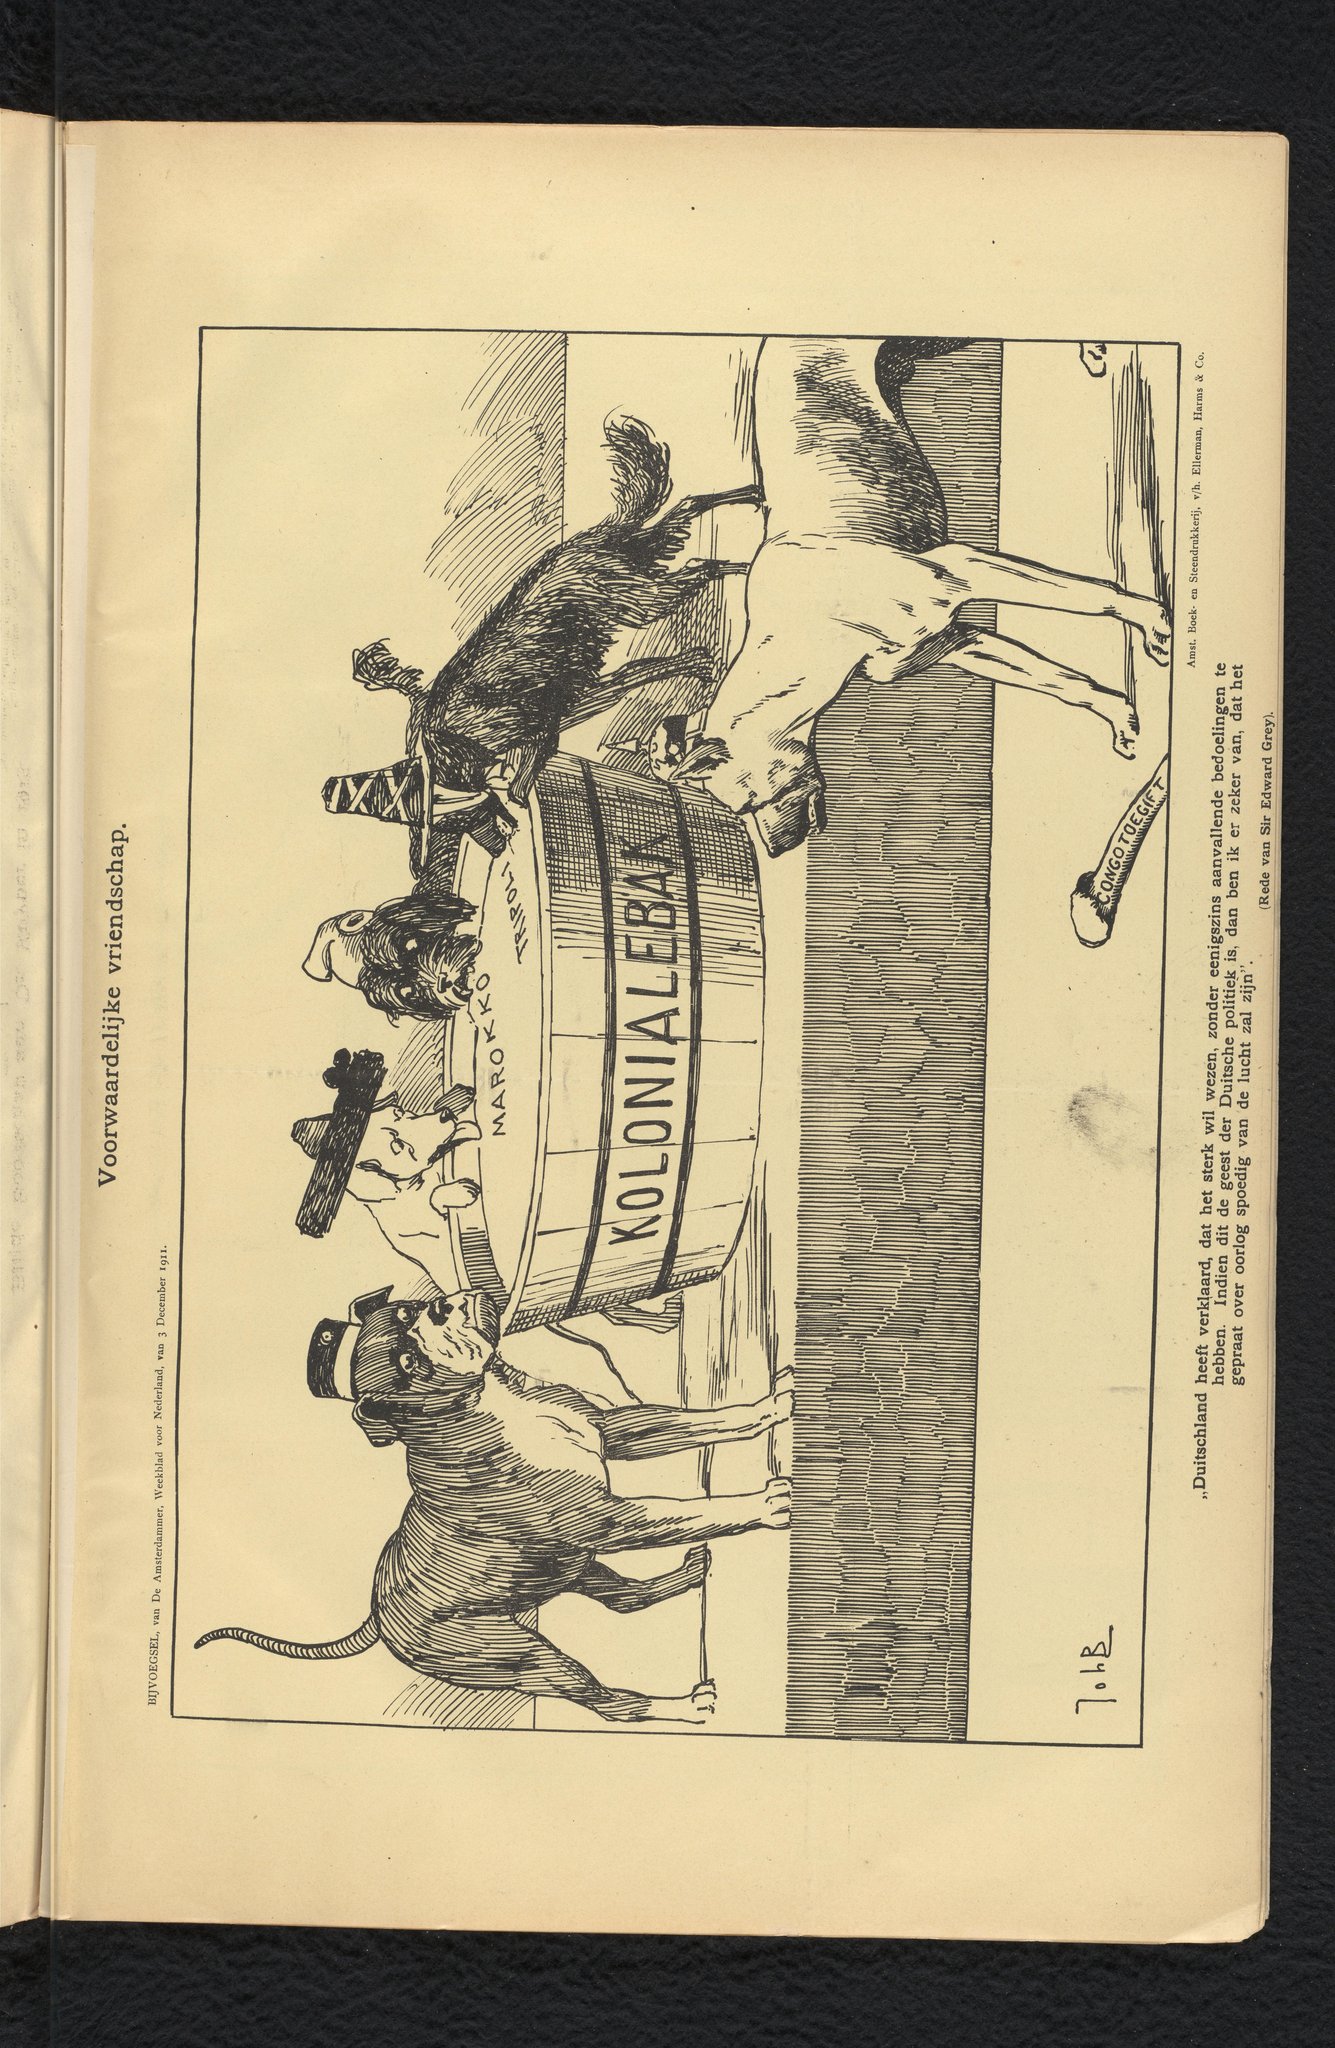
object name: cartoon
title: Voorwaardelijke vriendschap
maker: johan braakensiek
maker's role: draughtsman, print maker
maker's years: 1858-1940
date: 1911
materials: paper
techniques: lithograph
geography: netherlands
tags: personifications of countries, nations, states, districts, etc., colonial government, political caricatures and satires, dog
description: Een groep honden, de Europese koloniale mogendheden, drinkt water uit de 'koloniale bak', waarin Marokko en Tripoli staan vermeld. De Engelse bulldog kijkt argwanend naar de Duitse hond met het bot 'Congo toegift'. Onder de plaat een citaat uit een toespraak van Sir Edward Grey, de Engelse minister van Buitenlandse Zaken. Naar aanleiding van de Agadircrisis.